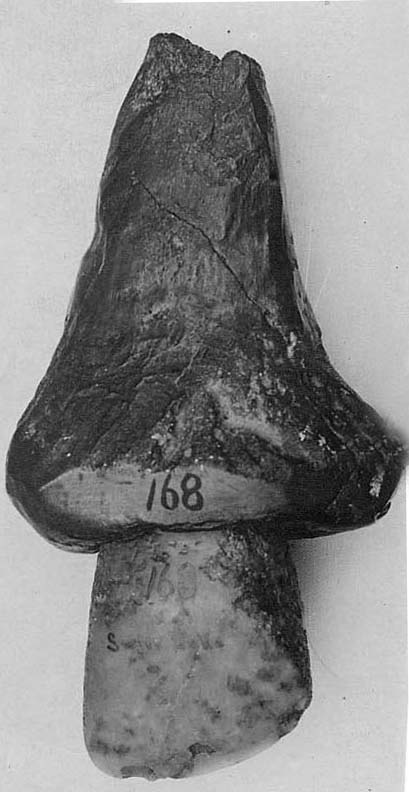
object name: hatchet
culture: swiss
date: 1902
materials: jade